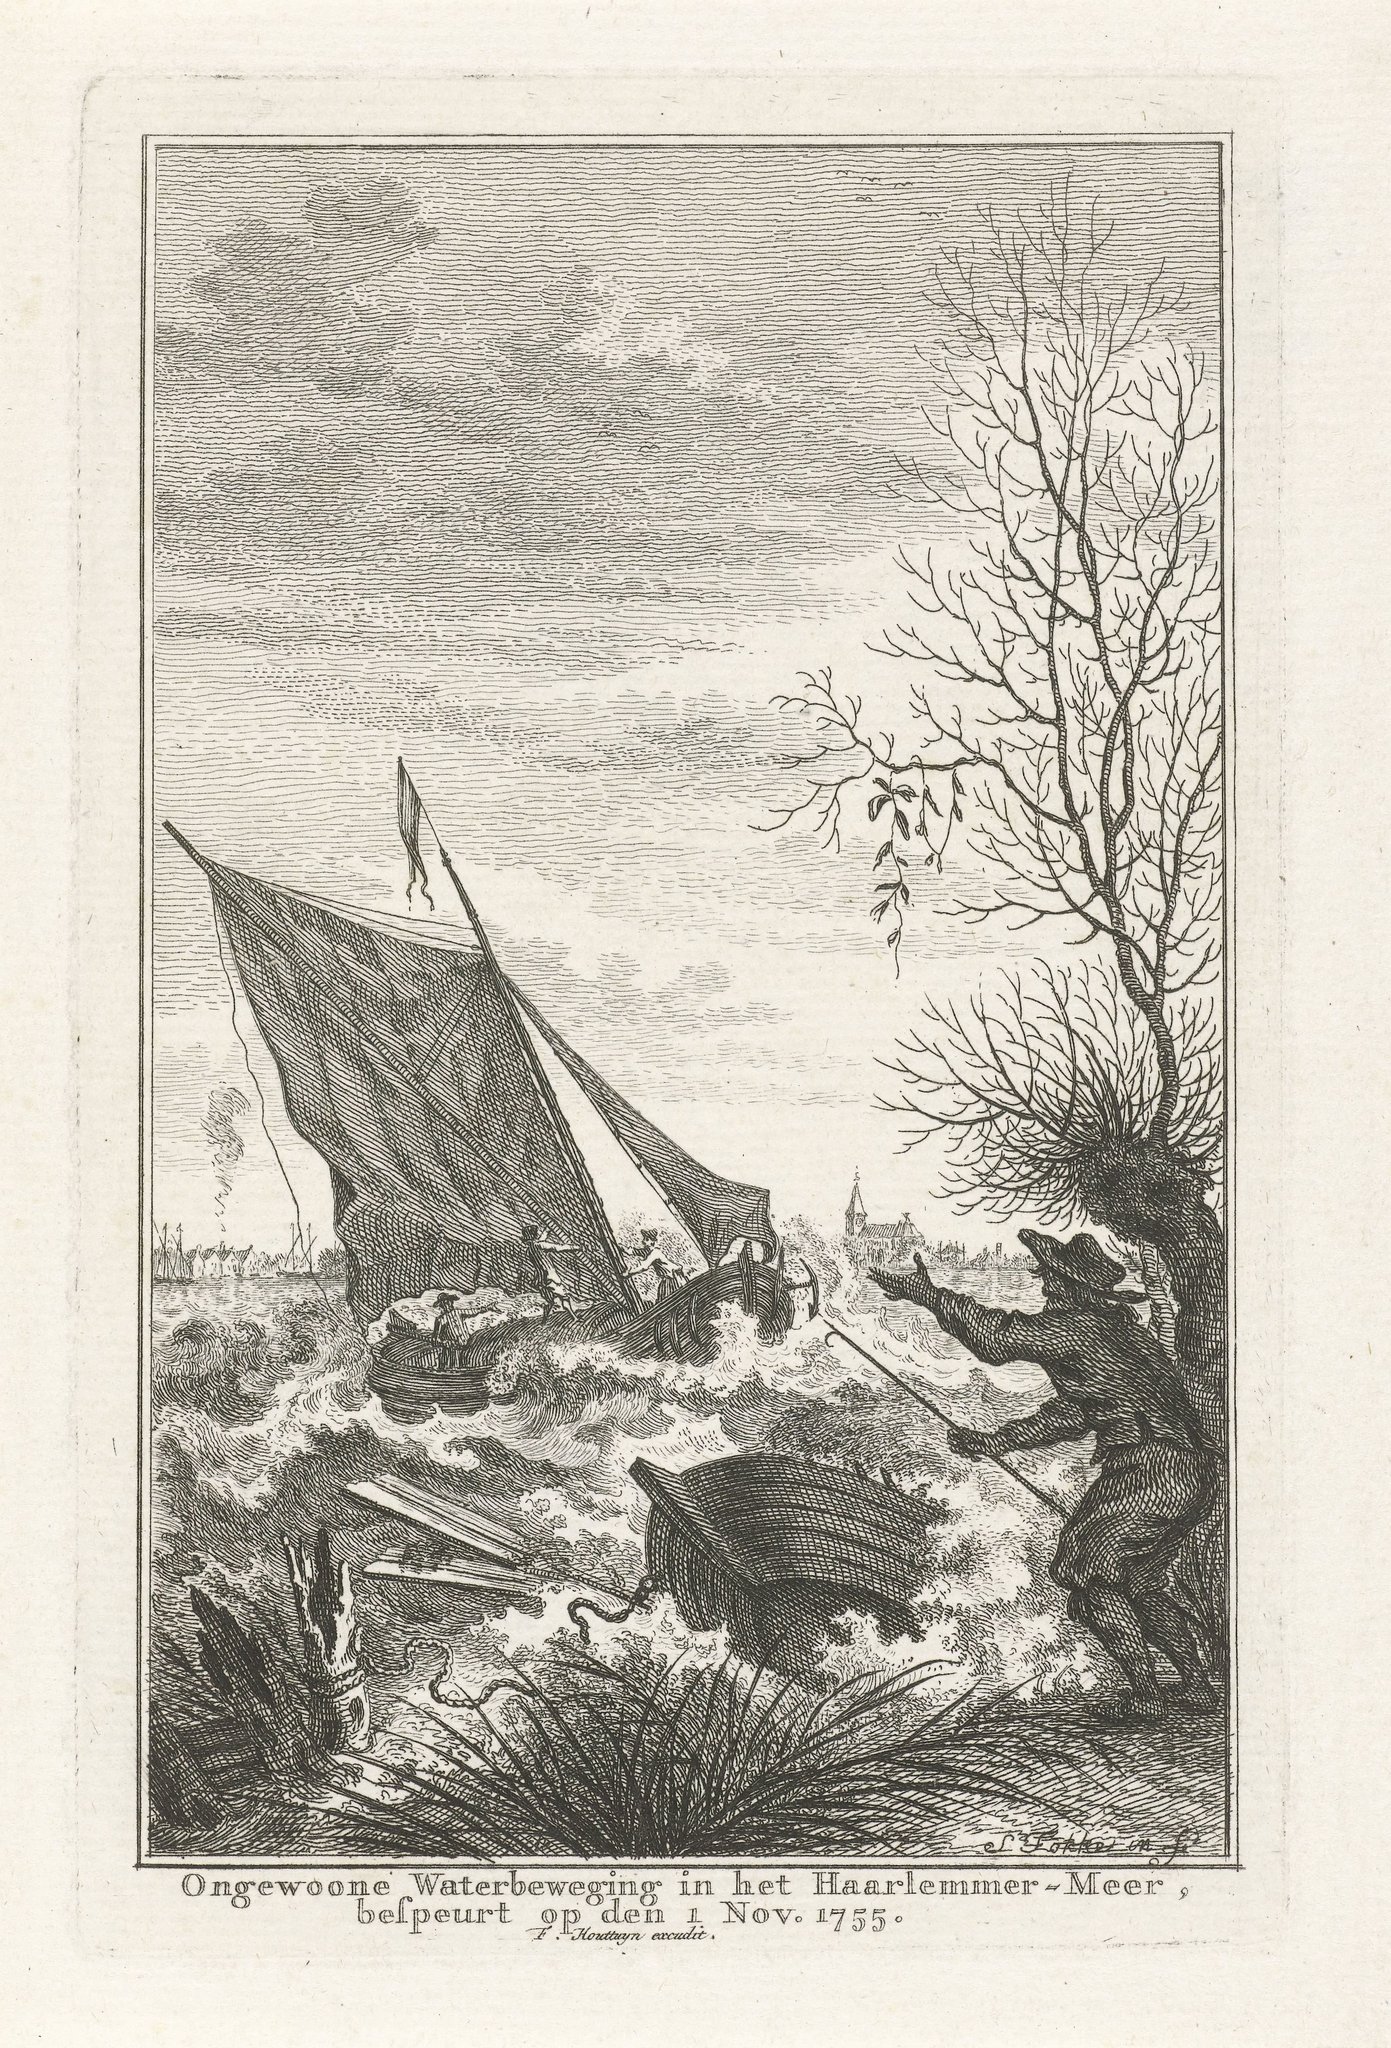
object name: print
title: Woelig water in het Haarlemmermeer, 1755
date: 1755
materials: paper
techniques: engraving, etching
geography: northern netherlands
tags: meteorological phenomena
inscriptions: collector's mark: Lugt 2228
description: Ongewoon woelig water, tijdens rustig weer, in het Haarlemmermeer op 1 november 1755. Op het water boten in nood, aan de oever kijkt een man toe.